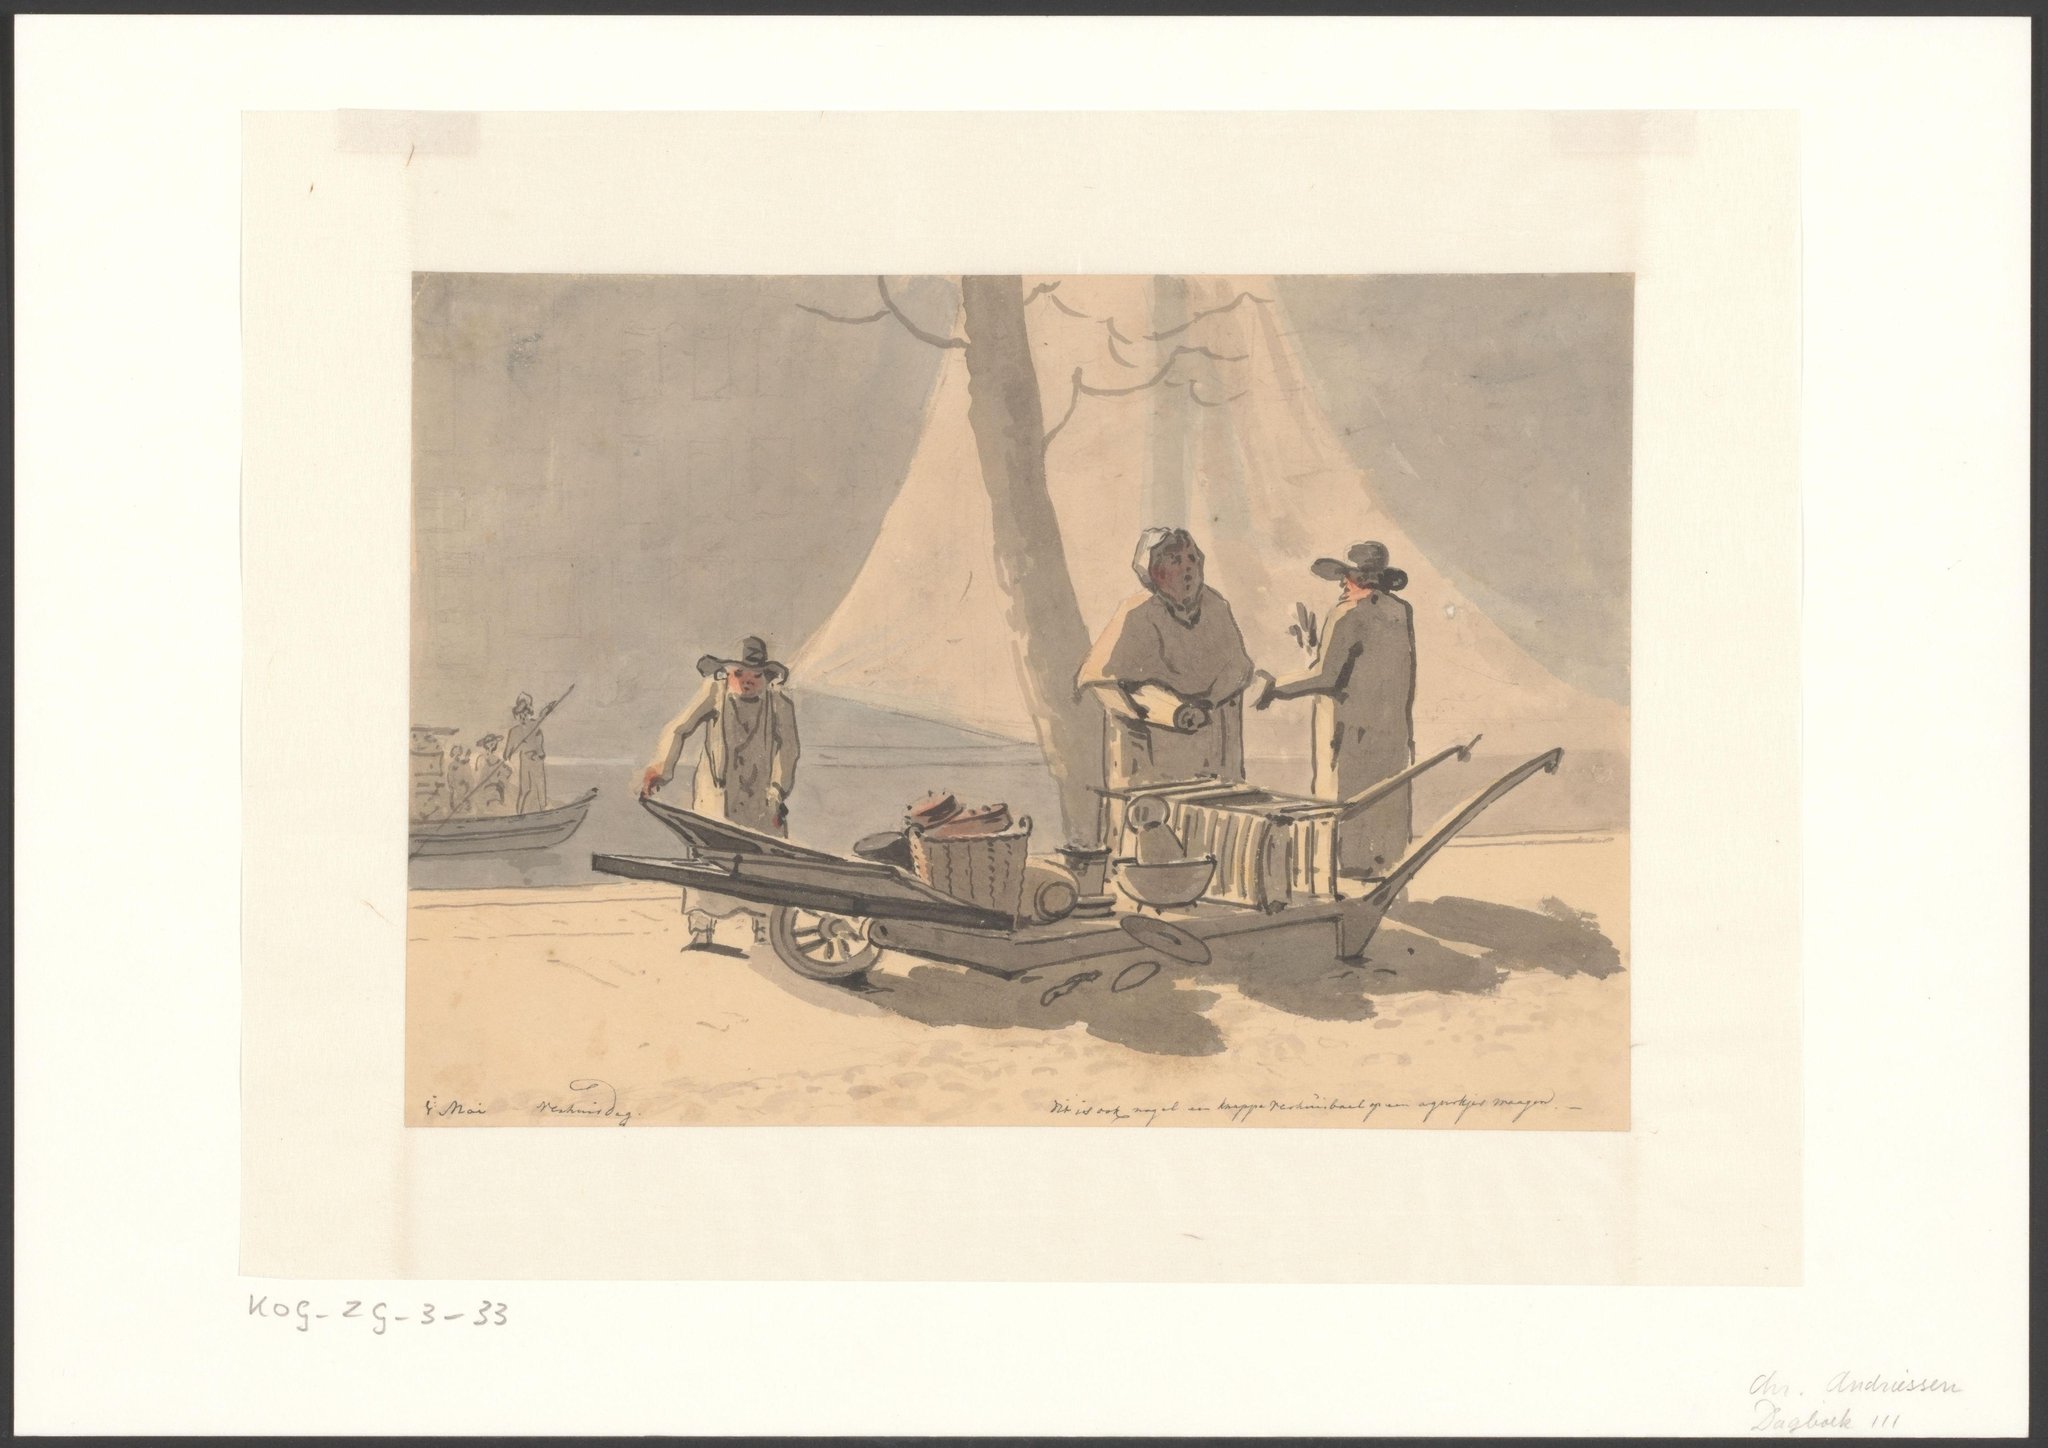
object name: drawing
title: Verhuizing met een kar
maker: christiaan andriessen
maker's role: draughtsman, print maker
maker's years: 1775-1846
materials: ink, paper, pencil, watercolor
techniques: brush, pen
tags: pouring, living-room, parlour, sitting-room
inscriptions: inscription: ‘J Andriessen’, inscription: ‘4 Mai verhuisdag Dit is ook nogal een knappe verhuisboel (...)’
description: Dagboekblad uit het getekende dagboek dat Christiaan Andriessen bijhield van 1805 tot en met 1808.